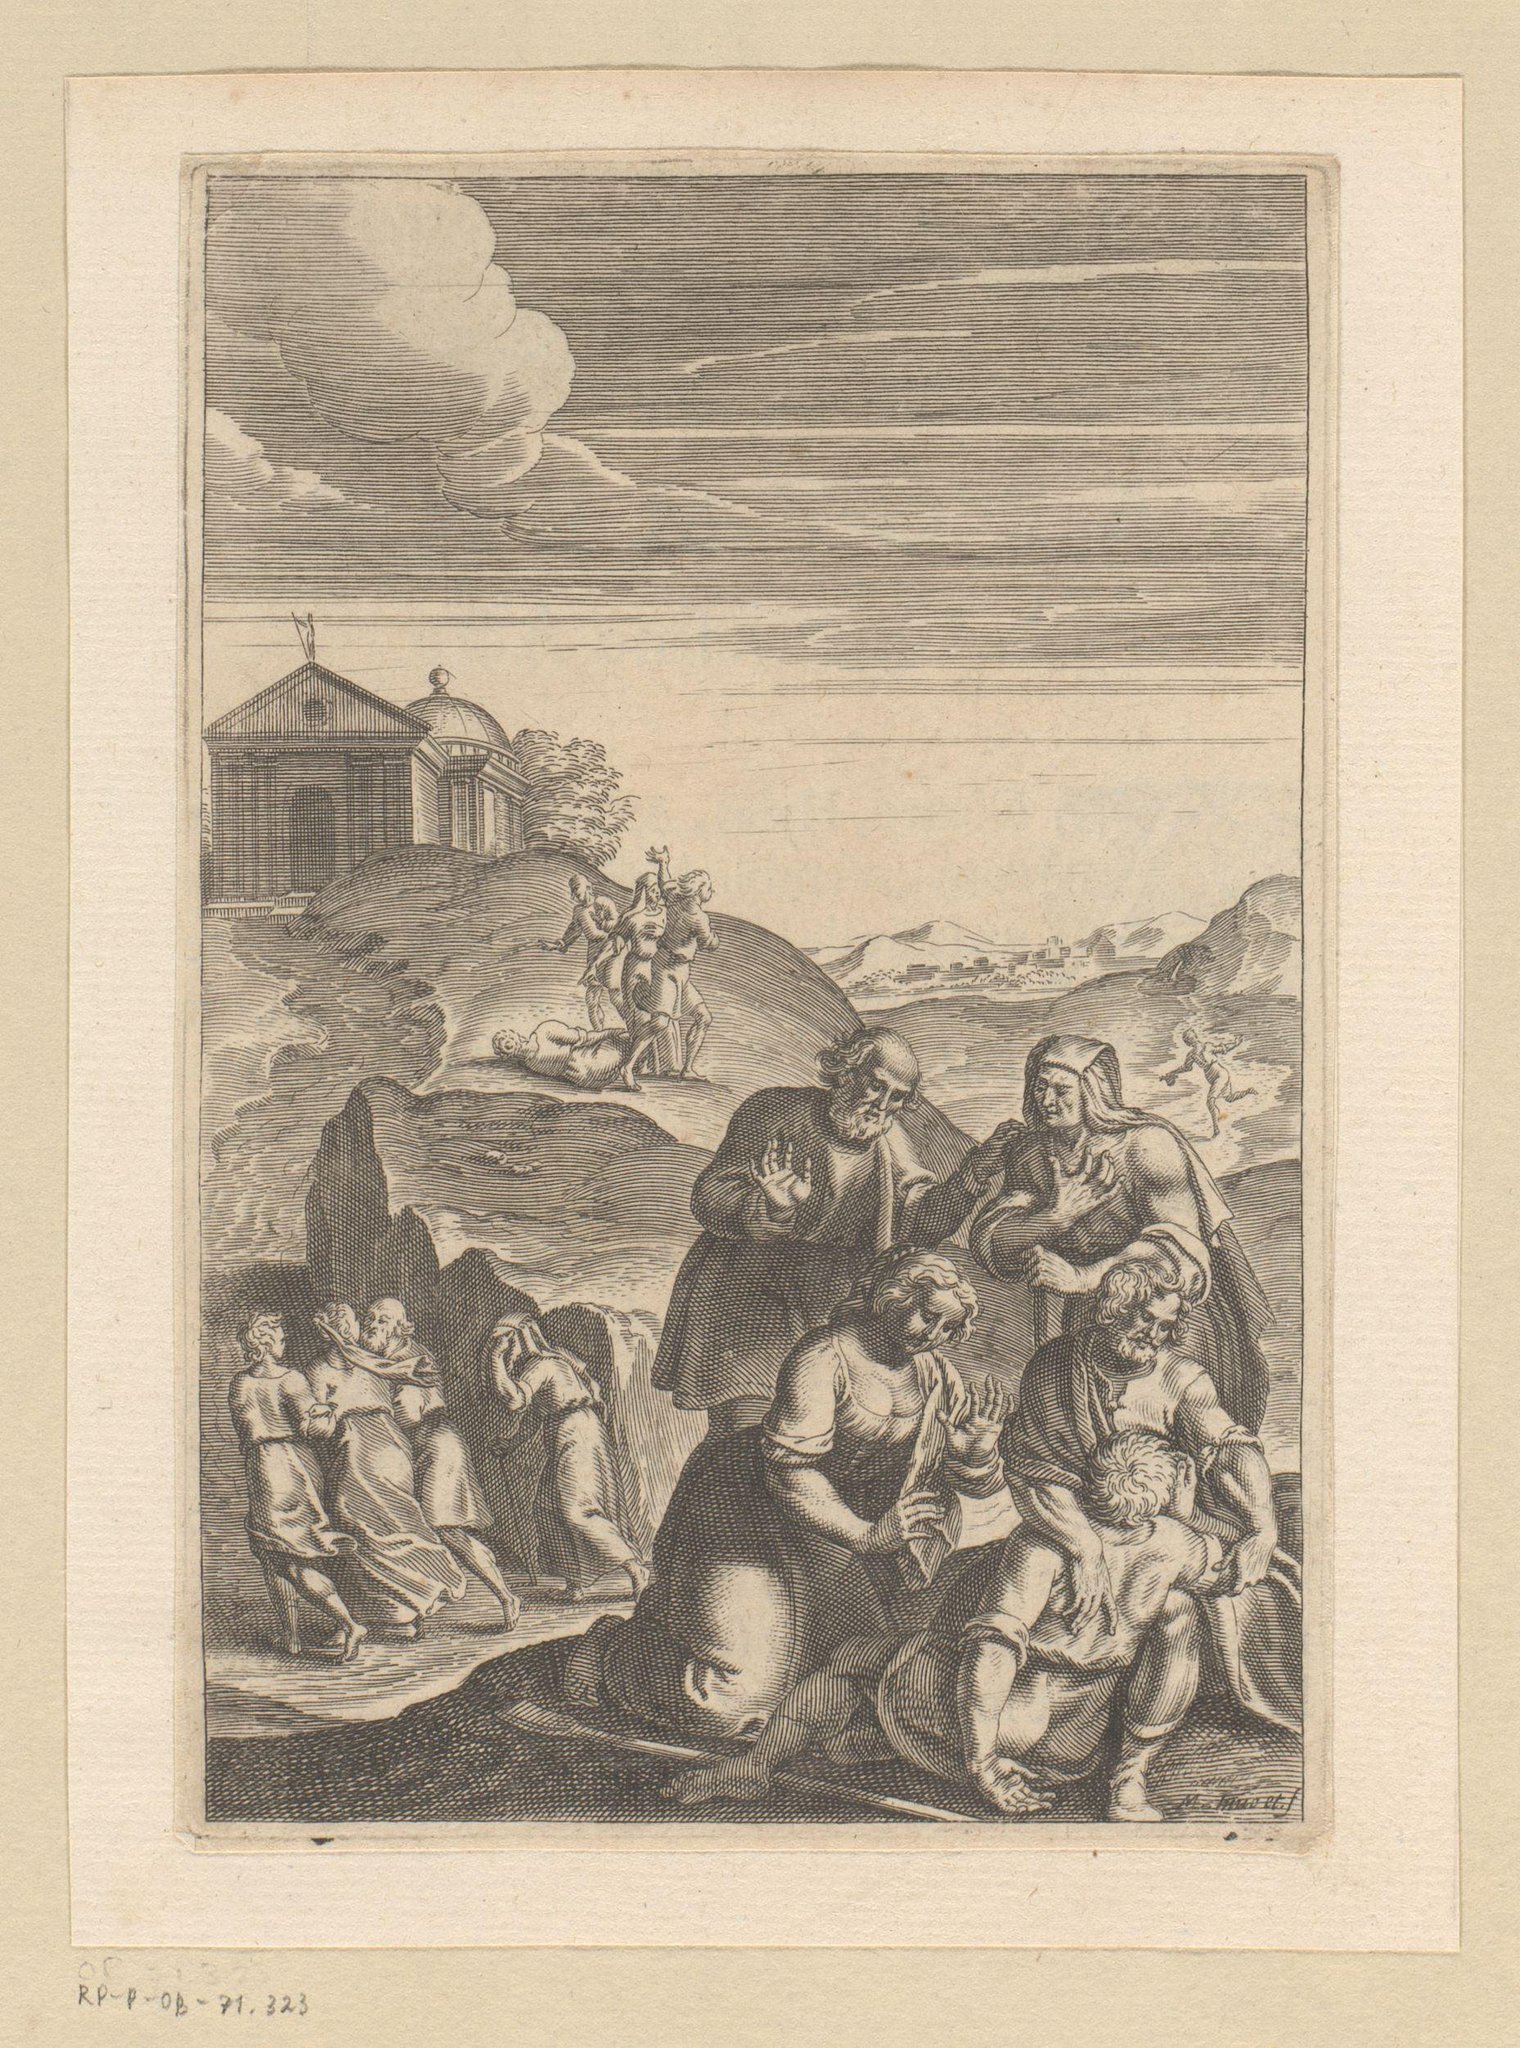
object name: book illustration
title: Menandre en Lerice met hun dochter Silvanire vinden op weg naar de tempel Agalante uitgeput in de armen van Hylas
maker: claude mellan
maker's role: draughtsman, print maker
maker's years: 1598-1688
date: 1608-1688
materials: paper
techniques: engraving, letterpress printing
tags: mountains